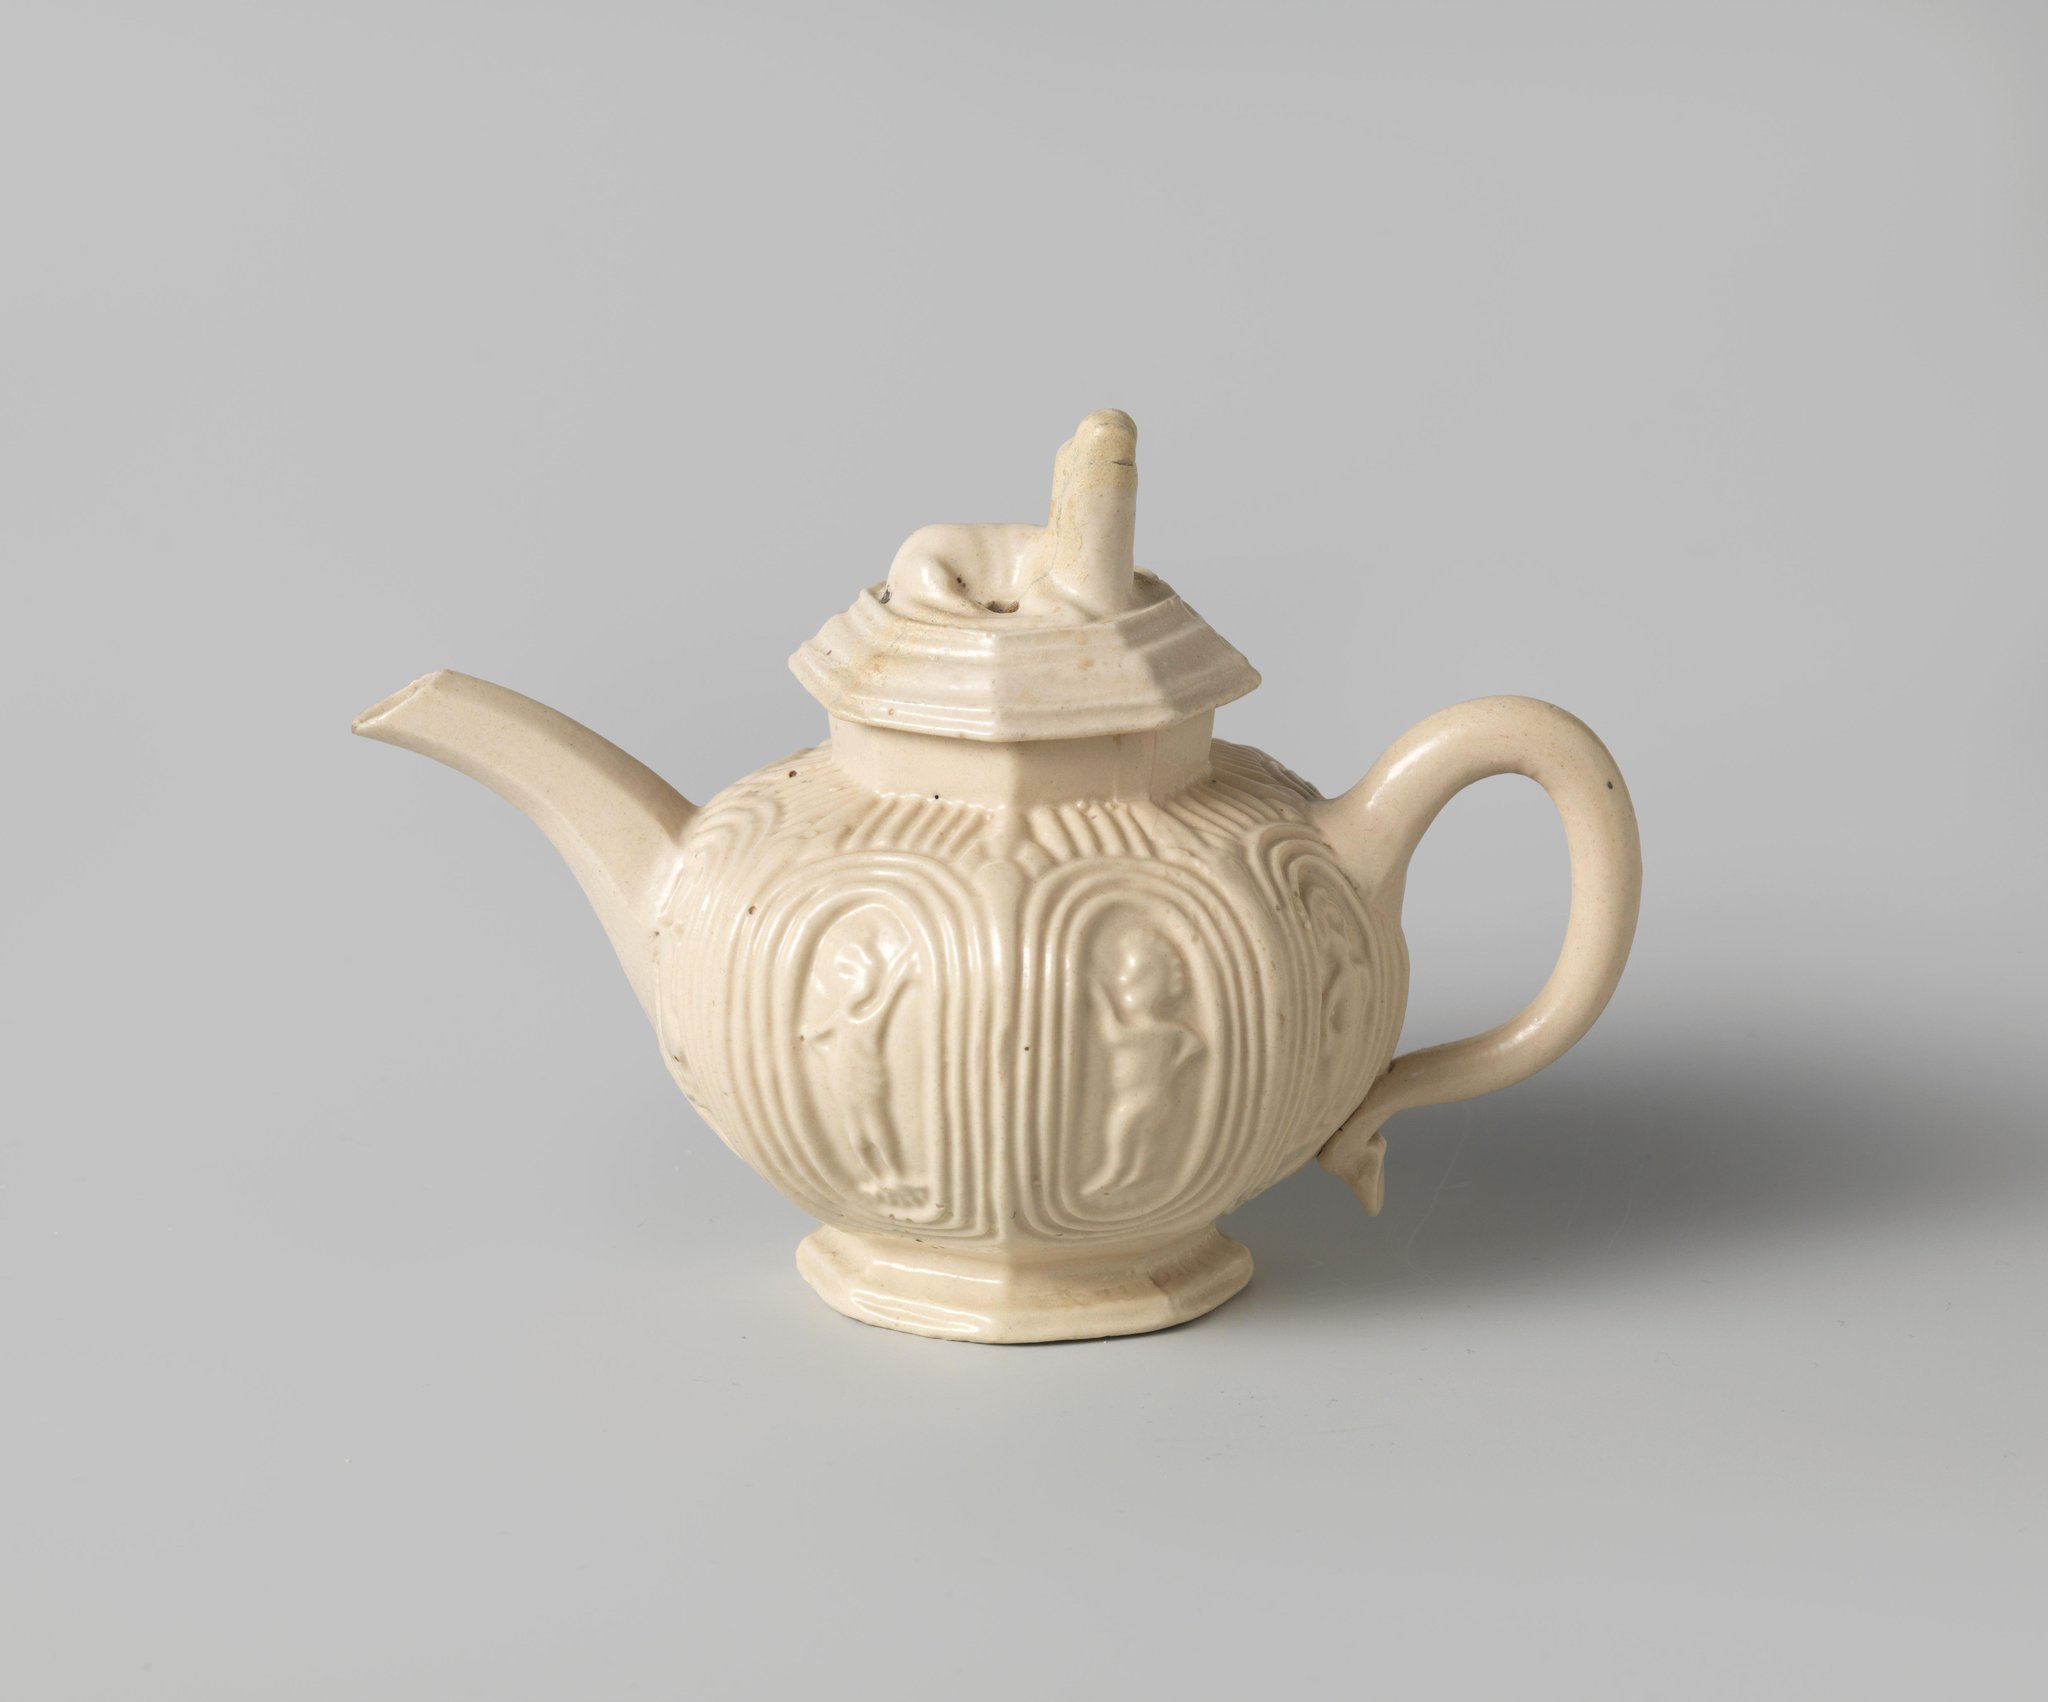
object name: pot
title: Theepot van wit steengoed met reliëffiguren; Crouch ware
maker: Anonymous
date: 1740-1760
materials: stoneware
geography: england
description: Achthoekige, bolvormige theepot van wit steengoed. De pot heeft een gebogen tuit, een C-vormig oor, een achthoekige standring en een achthoekig deksel. De pot heeft acht ovale medaillons in reliëf waarbinnen een figuur in reliëf.